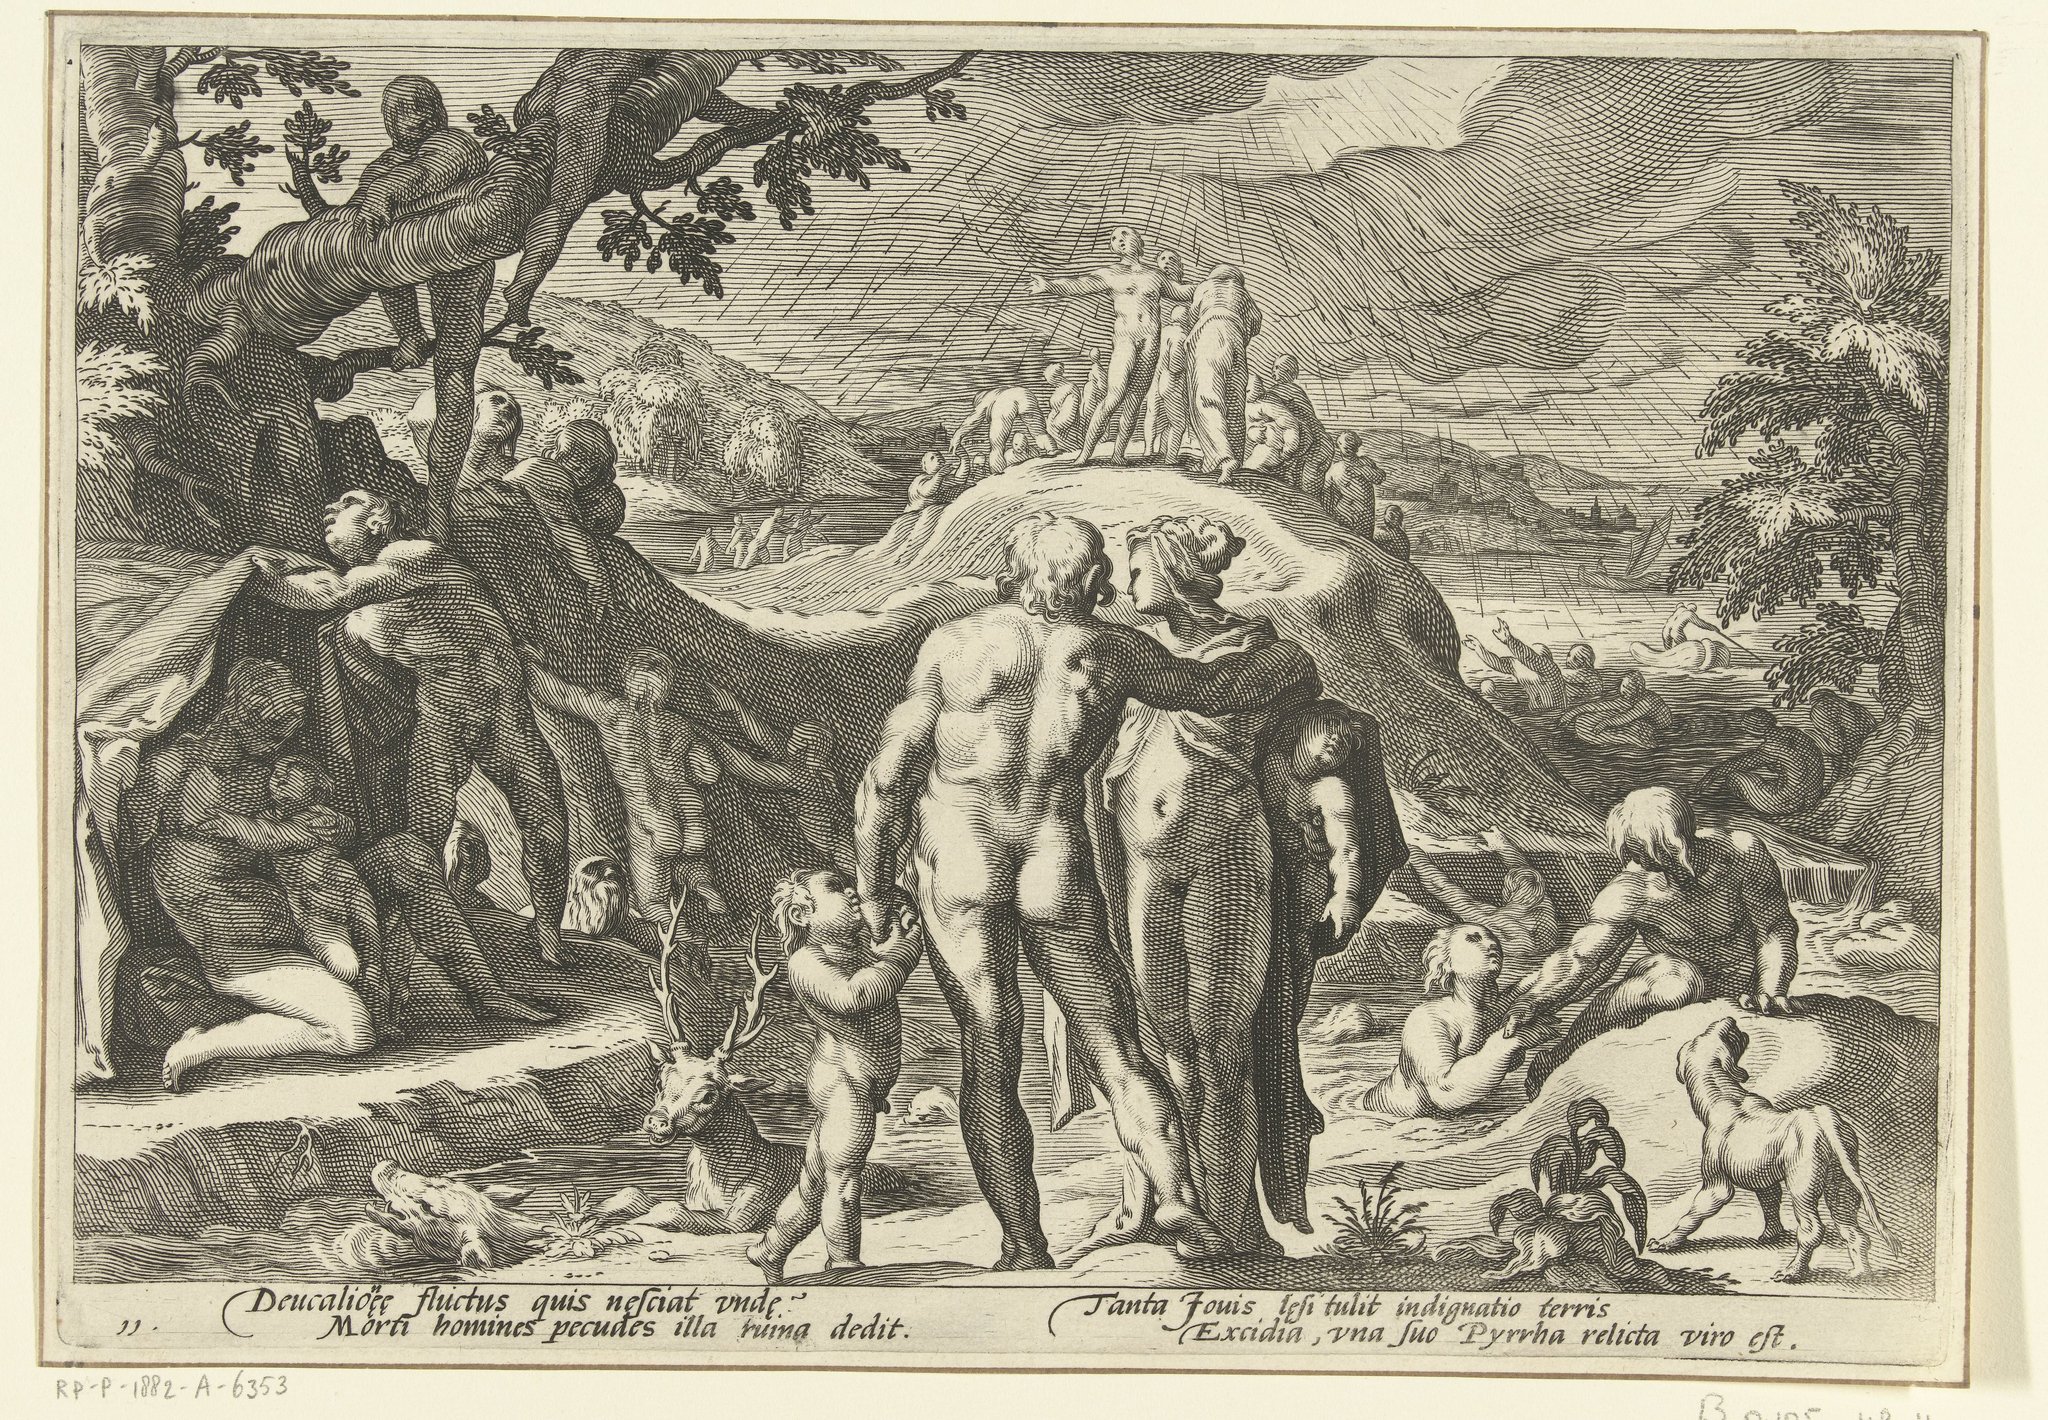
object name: print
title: Ovidius' Metamorfosen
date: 1589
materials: paper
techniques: engraving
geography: haarlem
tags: deucalion's flood; jupiter sends a great flood to destroy mankind; deucalion and pyrrha afloat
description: In een bergachtig landschap worden mensen en dieren getroffen door een zondvloed. Ze zoeken een veilig heenkomen op hoger gelegen plaatsen. Onder de voorstelling twee keer twee regels Latijnse tekst. Deze prent is onderdeel van een serie van 52 prenten die verhalen uit Ovidius' Metamorfosen verbeelden. Deze serie valt uiteen in drie genummerde reeksen: twee van 20 prenten en één van 12 prenten. Deze prent behoort tot de eerste reeks.